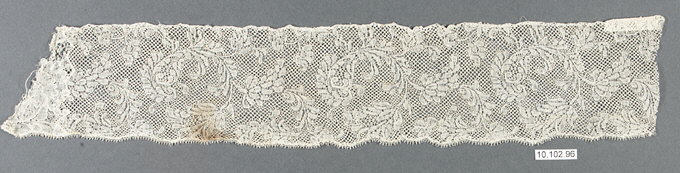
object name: strip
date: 1701-1800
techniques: lace